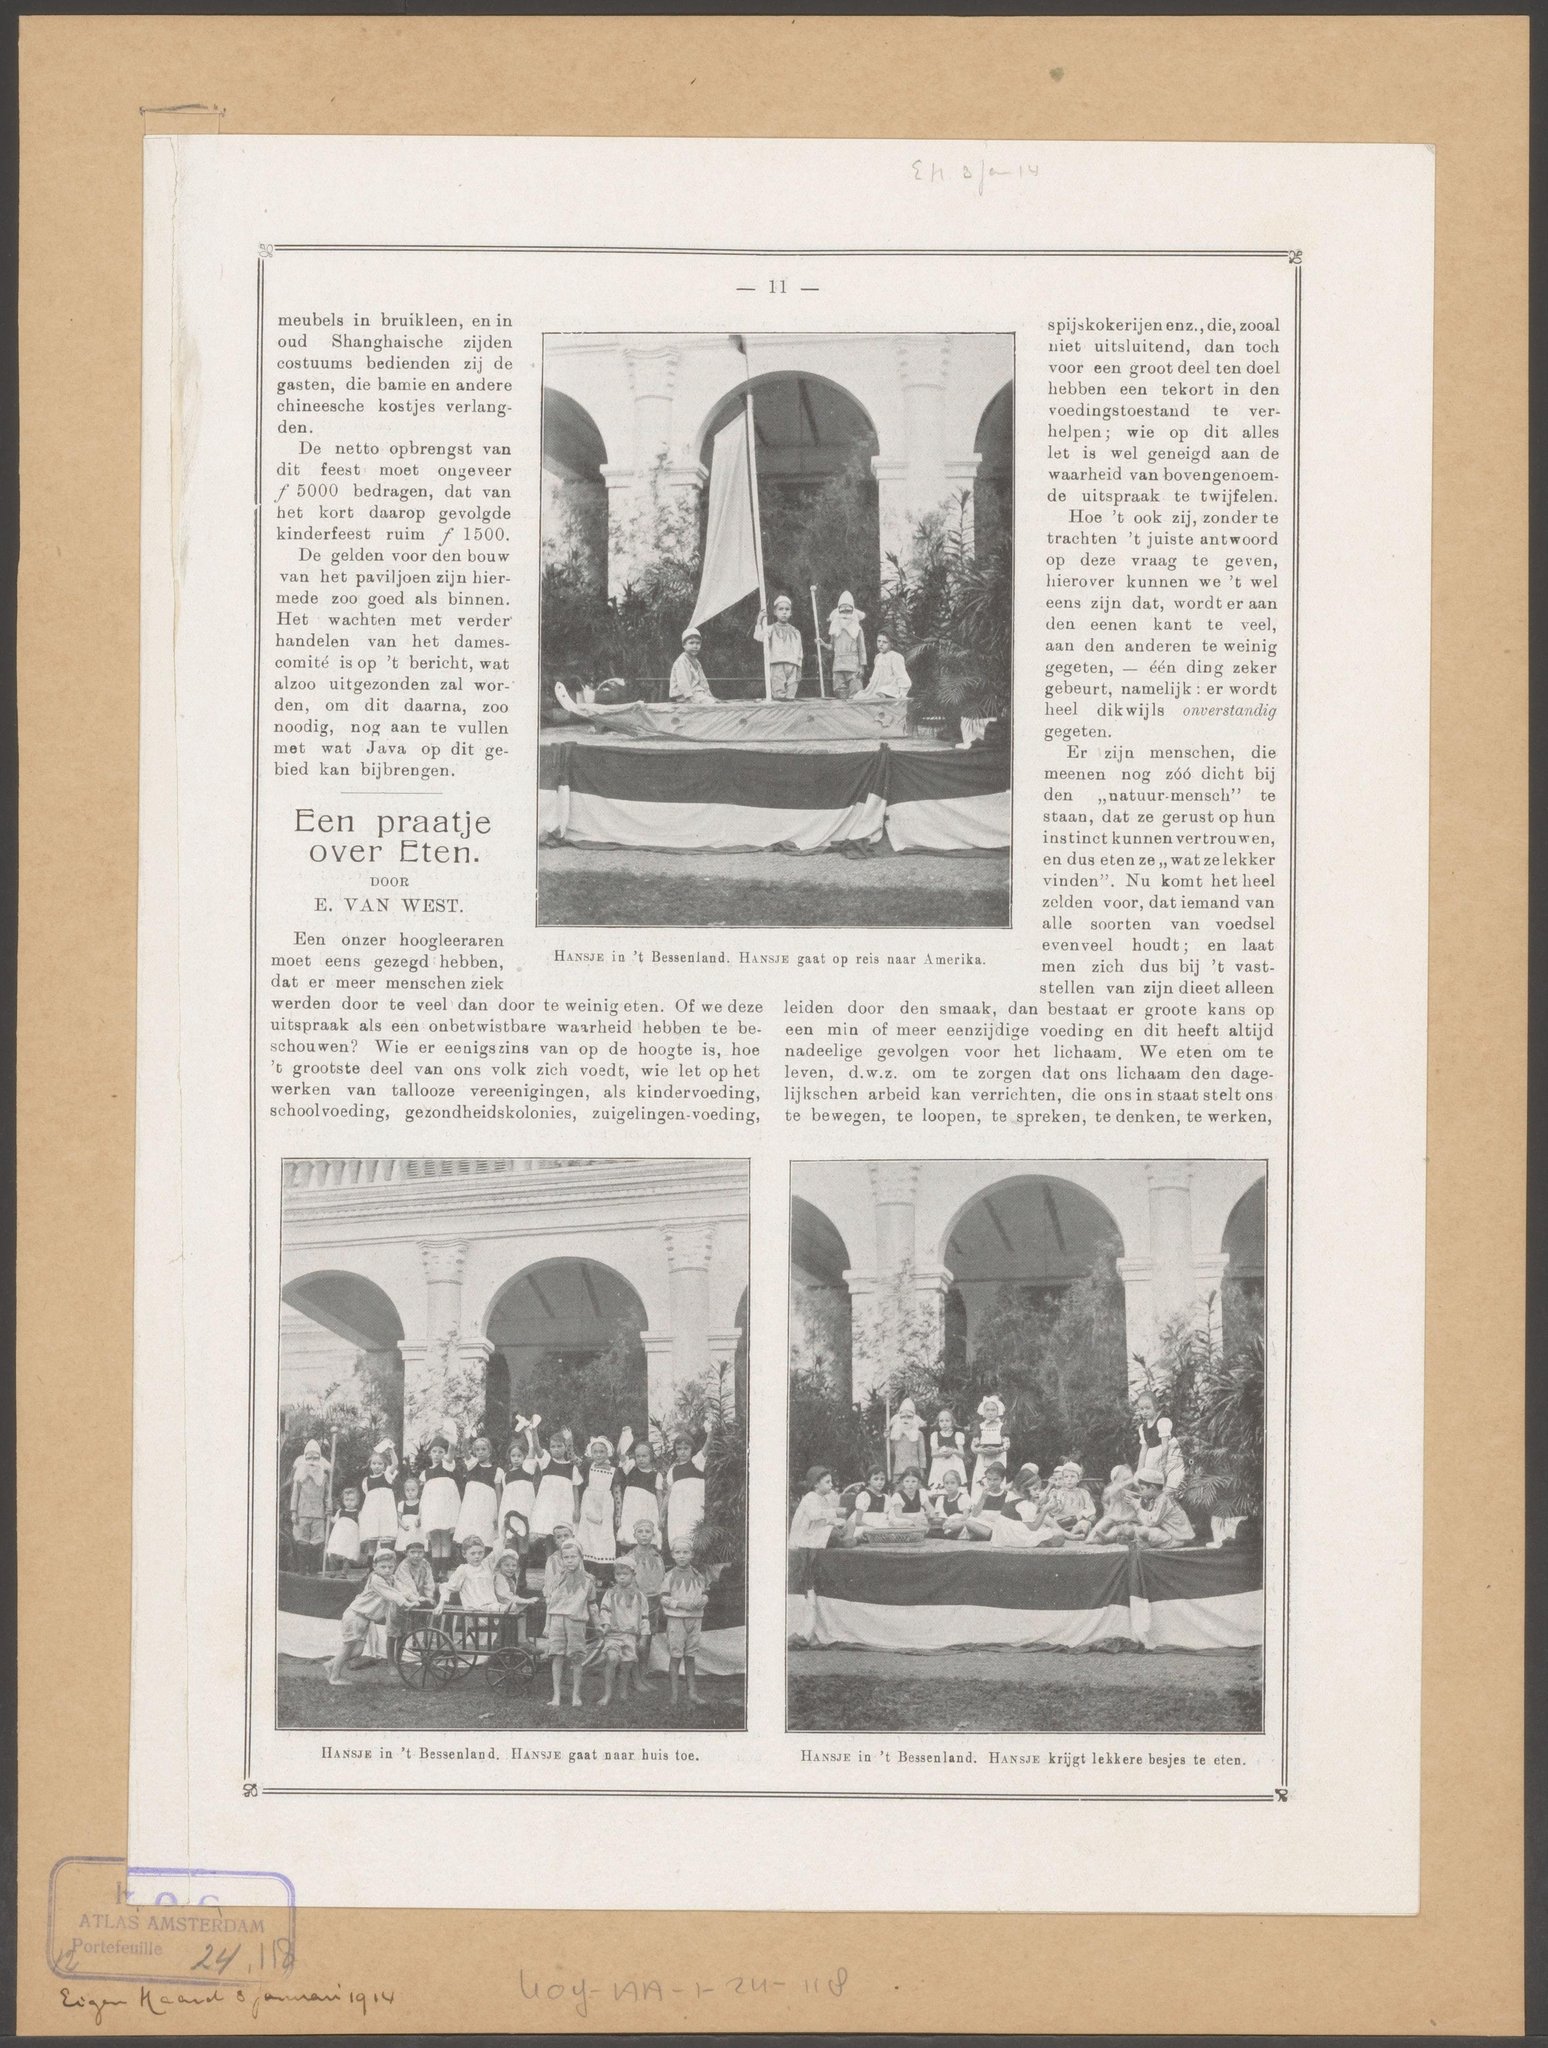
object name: article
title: De nieuwe hoofdcommissaris van Politie van Amsterdam, F.M. Roest van Limburg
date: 1914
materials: paper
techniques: letterpress printing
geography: netherlands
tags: historical persons, police, amsterdam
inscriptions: collector's mark: Lugt 1641b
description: Object bestaat uit twee pagina's. Het portret van de Amsterdamse hoofdcommissaris Theodorus Marinus Roest van Limburg bevindt zich op recto van de tweede pagina, op bladzijde 13. Onderwerpsrubriek binnen de Atlas Amsterdam: Politie.